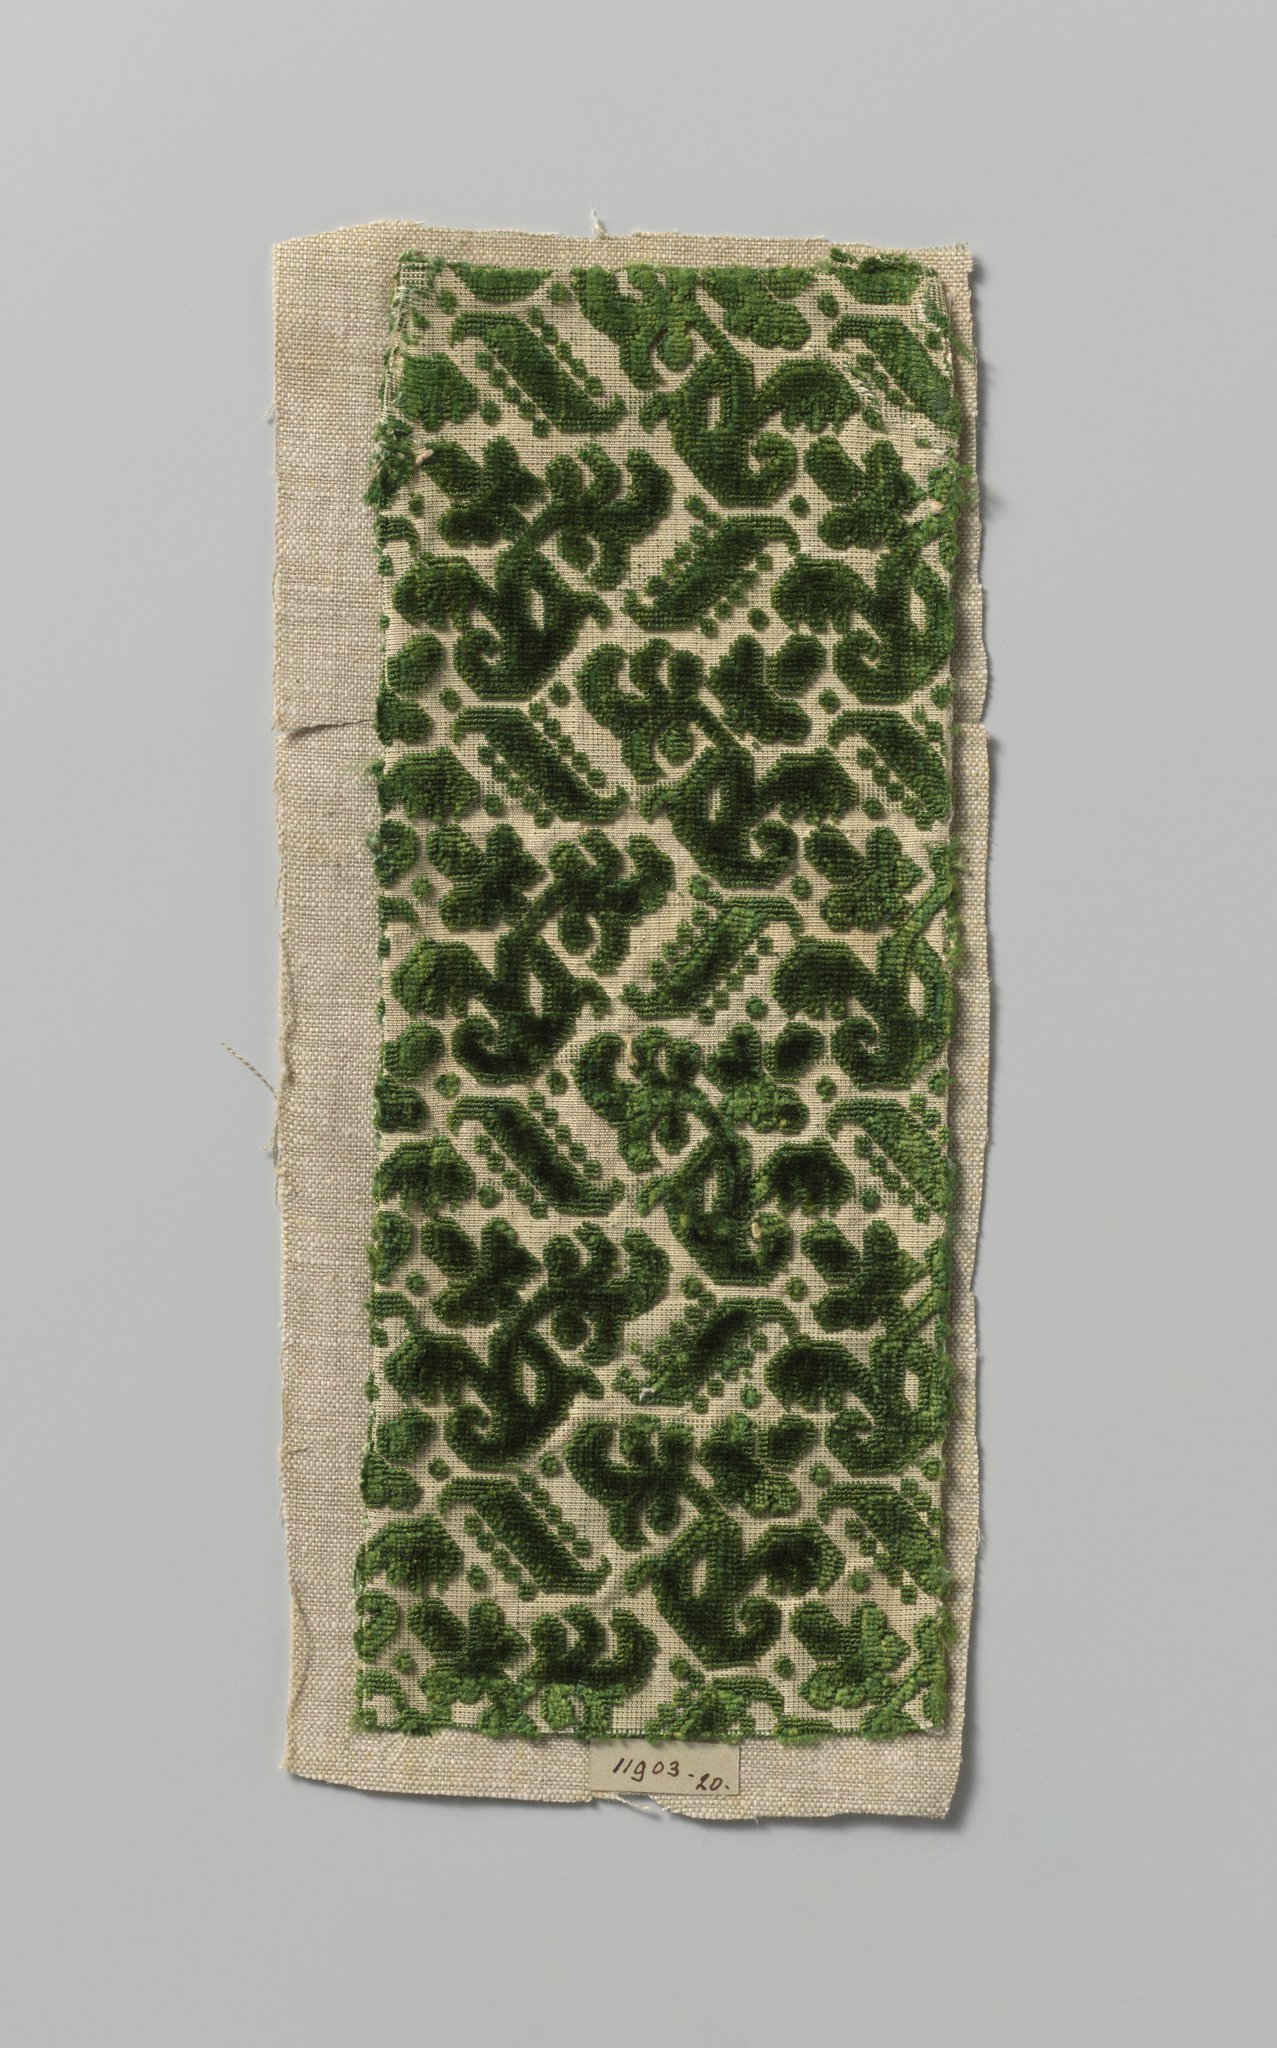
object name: zijdefluweel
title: Fragment zijdefluweel met uitsparingen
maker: Anonymous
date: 1500-1599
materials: silk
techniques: velvet, weave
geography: italy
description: Fragment zijdefluweel met op lichte fond in ongelijke rijen geplaatste gestileerde bloemtakken en voluten met blokken in groen. Italië, 16de eeuw.